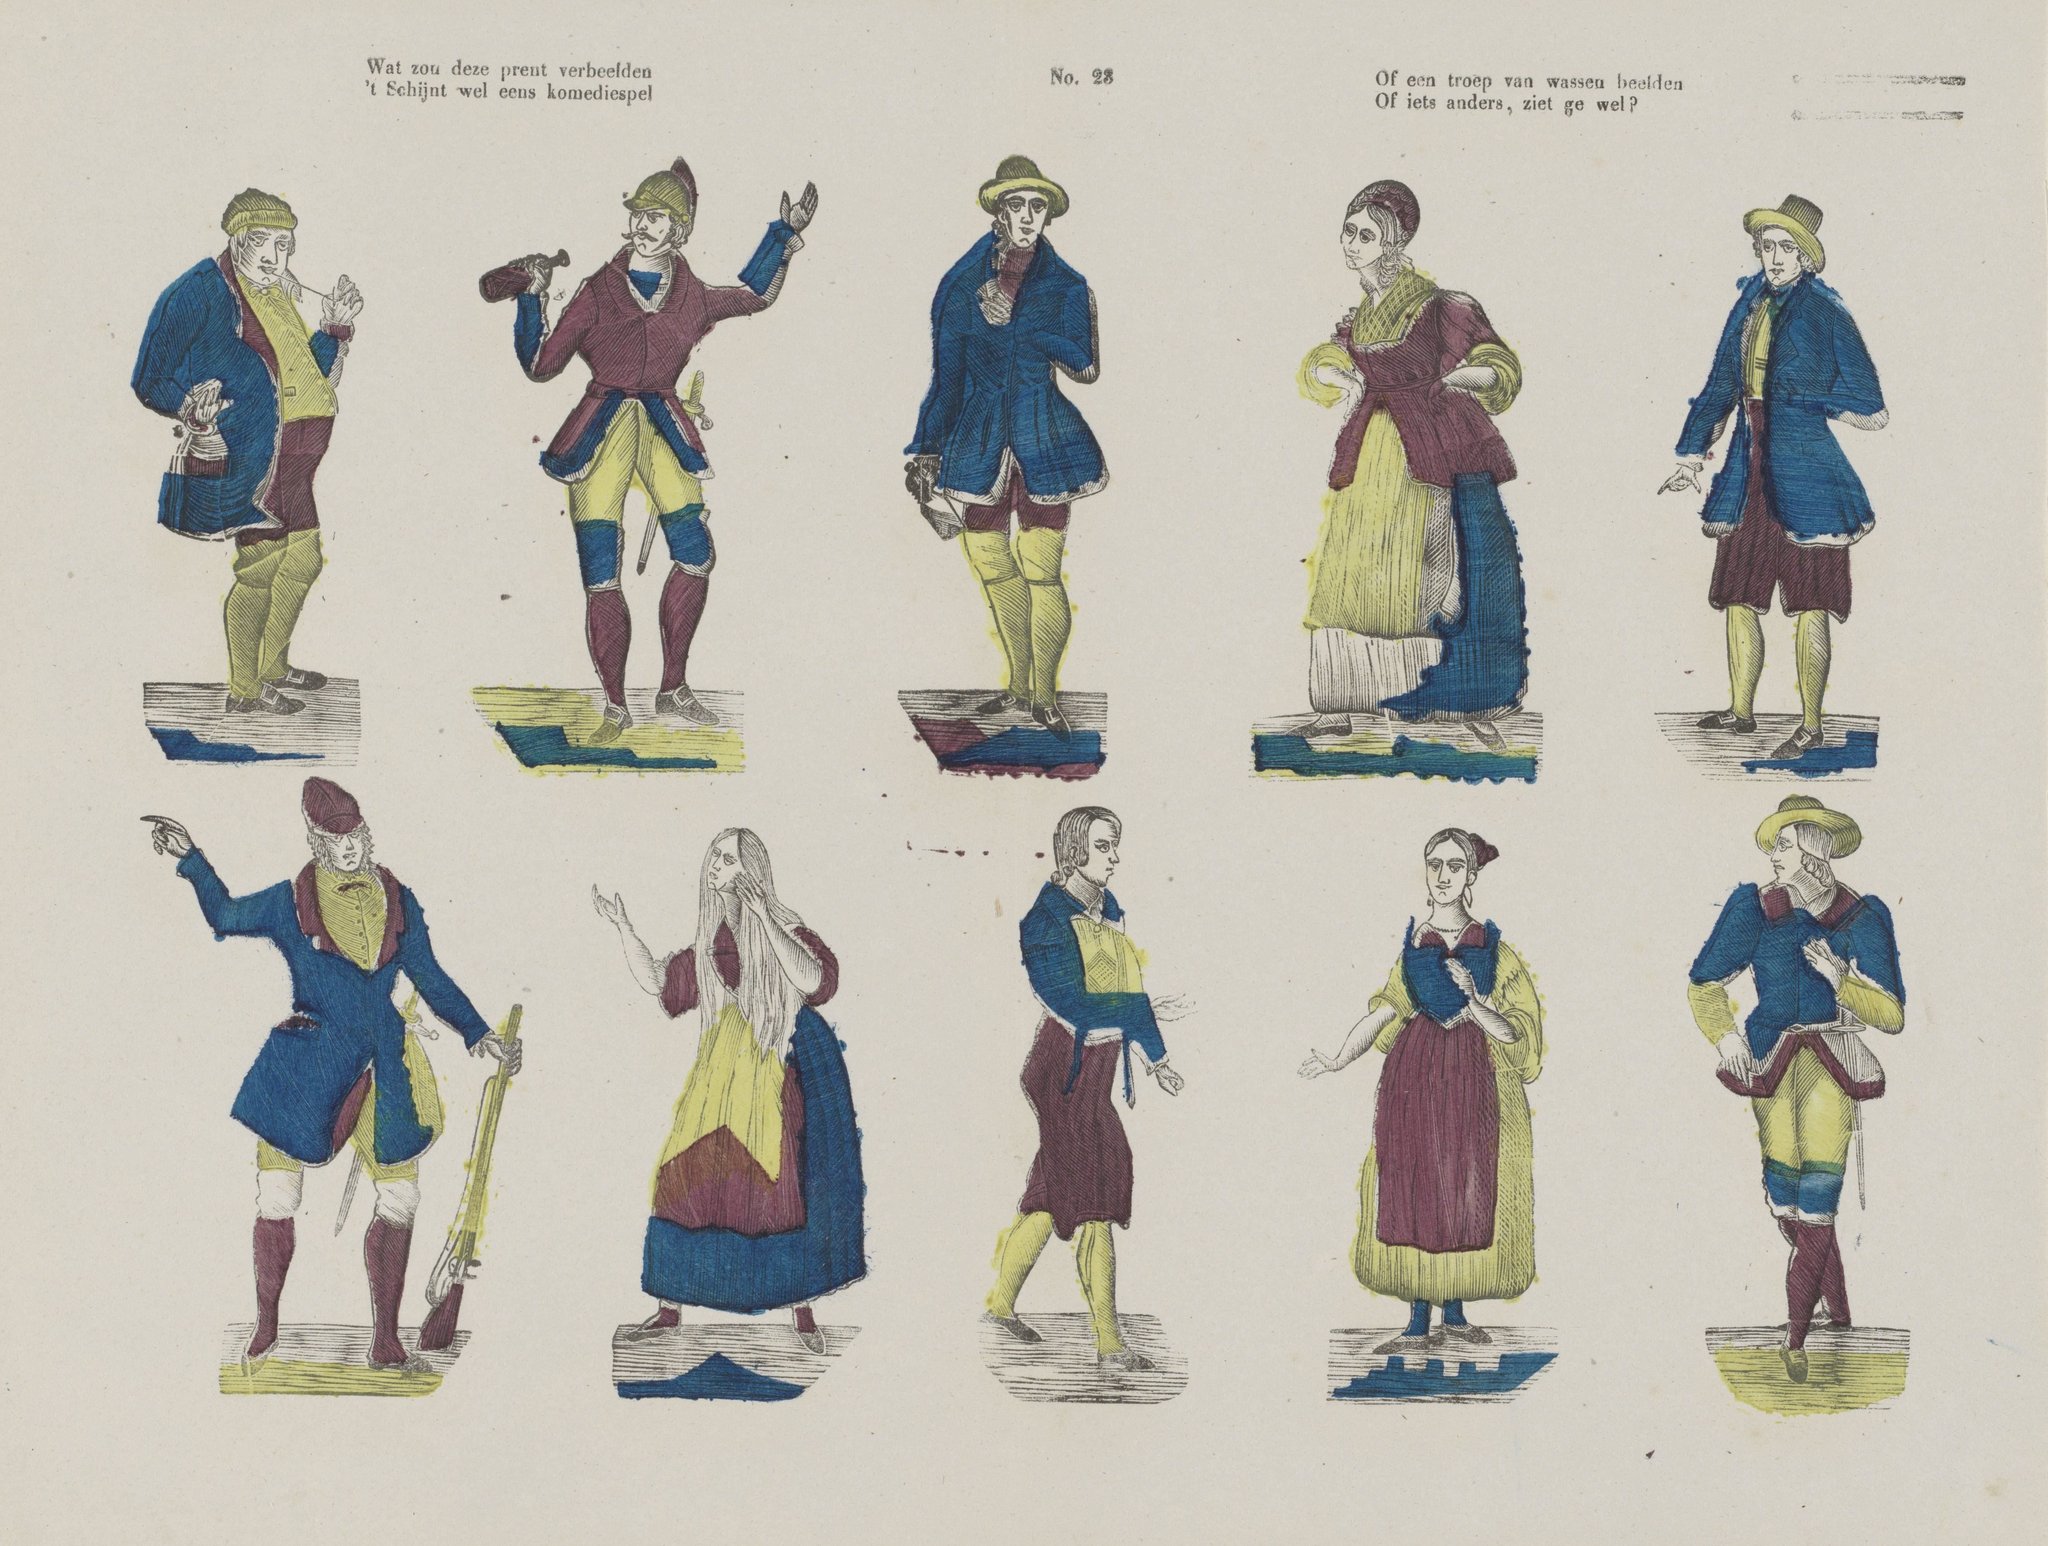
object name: print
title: Wat zou deze prent verbeelden / 't schijnt wel eens komediespel / Of een troep van wassen beelden / Of iets anders, ziet ge wel?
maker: Anonymous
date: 1848-1881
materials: paper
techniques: colour, letterpress printing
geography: netherlands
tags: actress (on the stage), actor (on the stage)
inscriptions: collector's mark: Lugt 2760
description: Blad met 10 voorstellingen van theaterpersonages. Genummerd midden boven: No. 23.